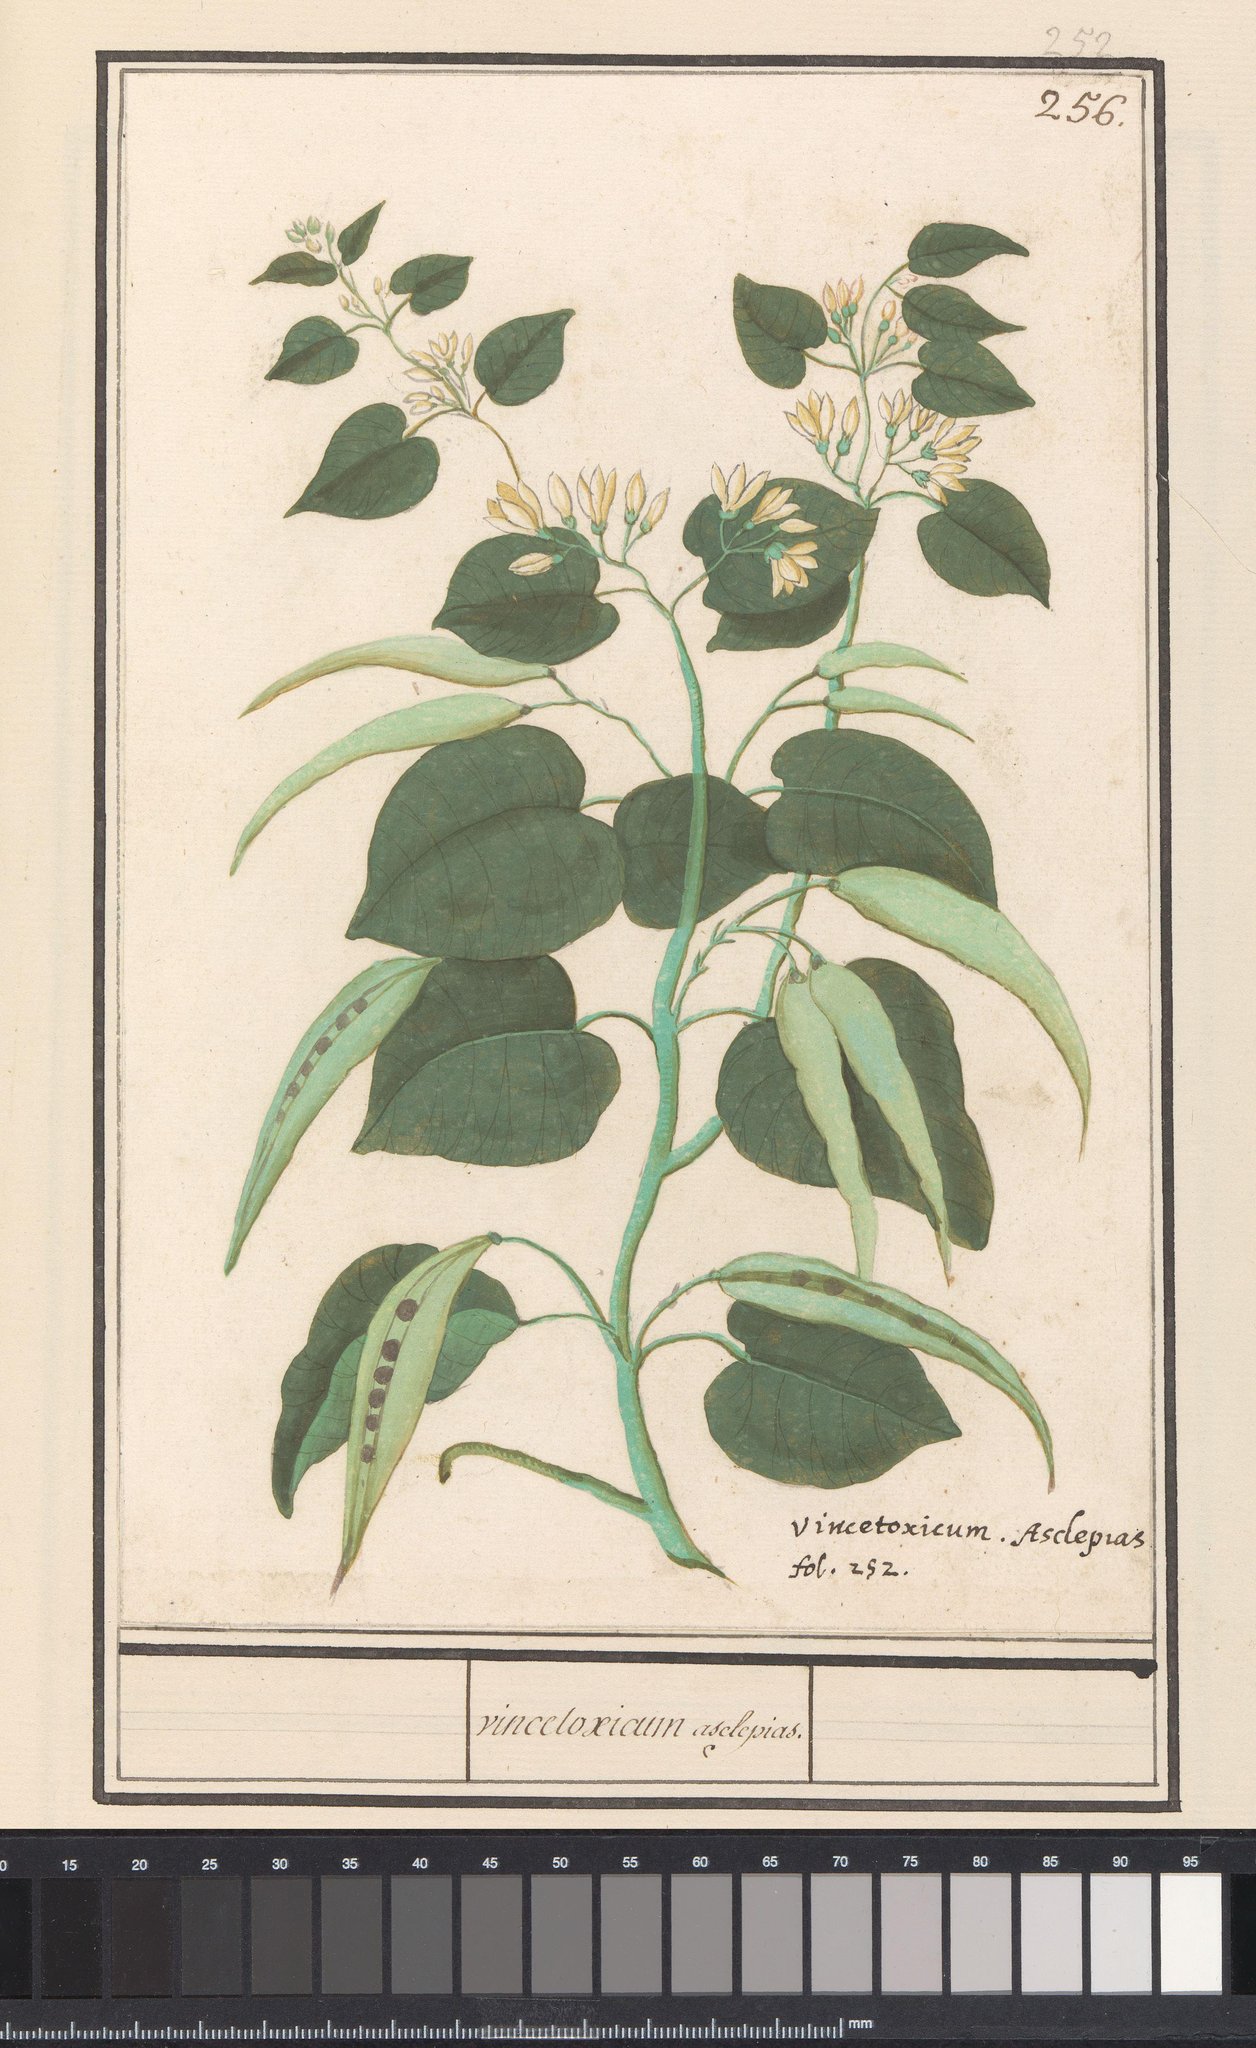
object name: drawing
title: Common Milkweed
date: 1596-1610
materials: chalk, paint, ink, paper, watercolor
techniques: brush, pen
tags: flowers: common milkweed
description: This drawing of a milkweed plant was certainly not done from life. Various stages of flowering, which in reality never occur at the same time, are shown simultaneously on a single branch. The plant bears both flowers and seedpods. It is more a generic image of the milkweed than a portrait of a specific specimen. De Boodt did this deliberately to facilitate identification.